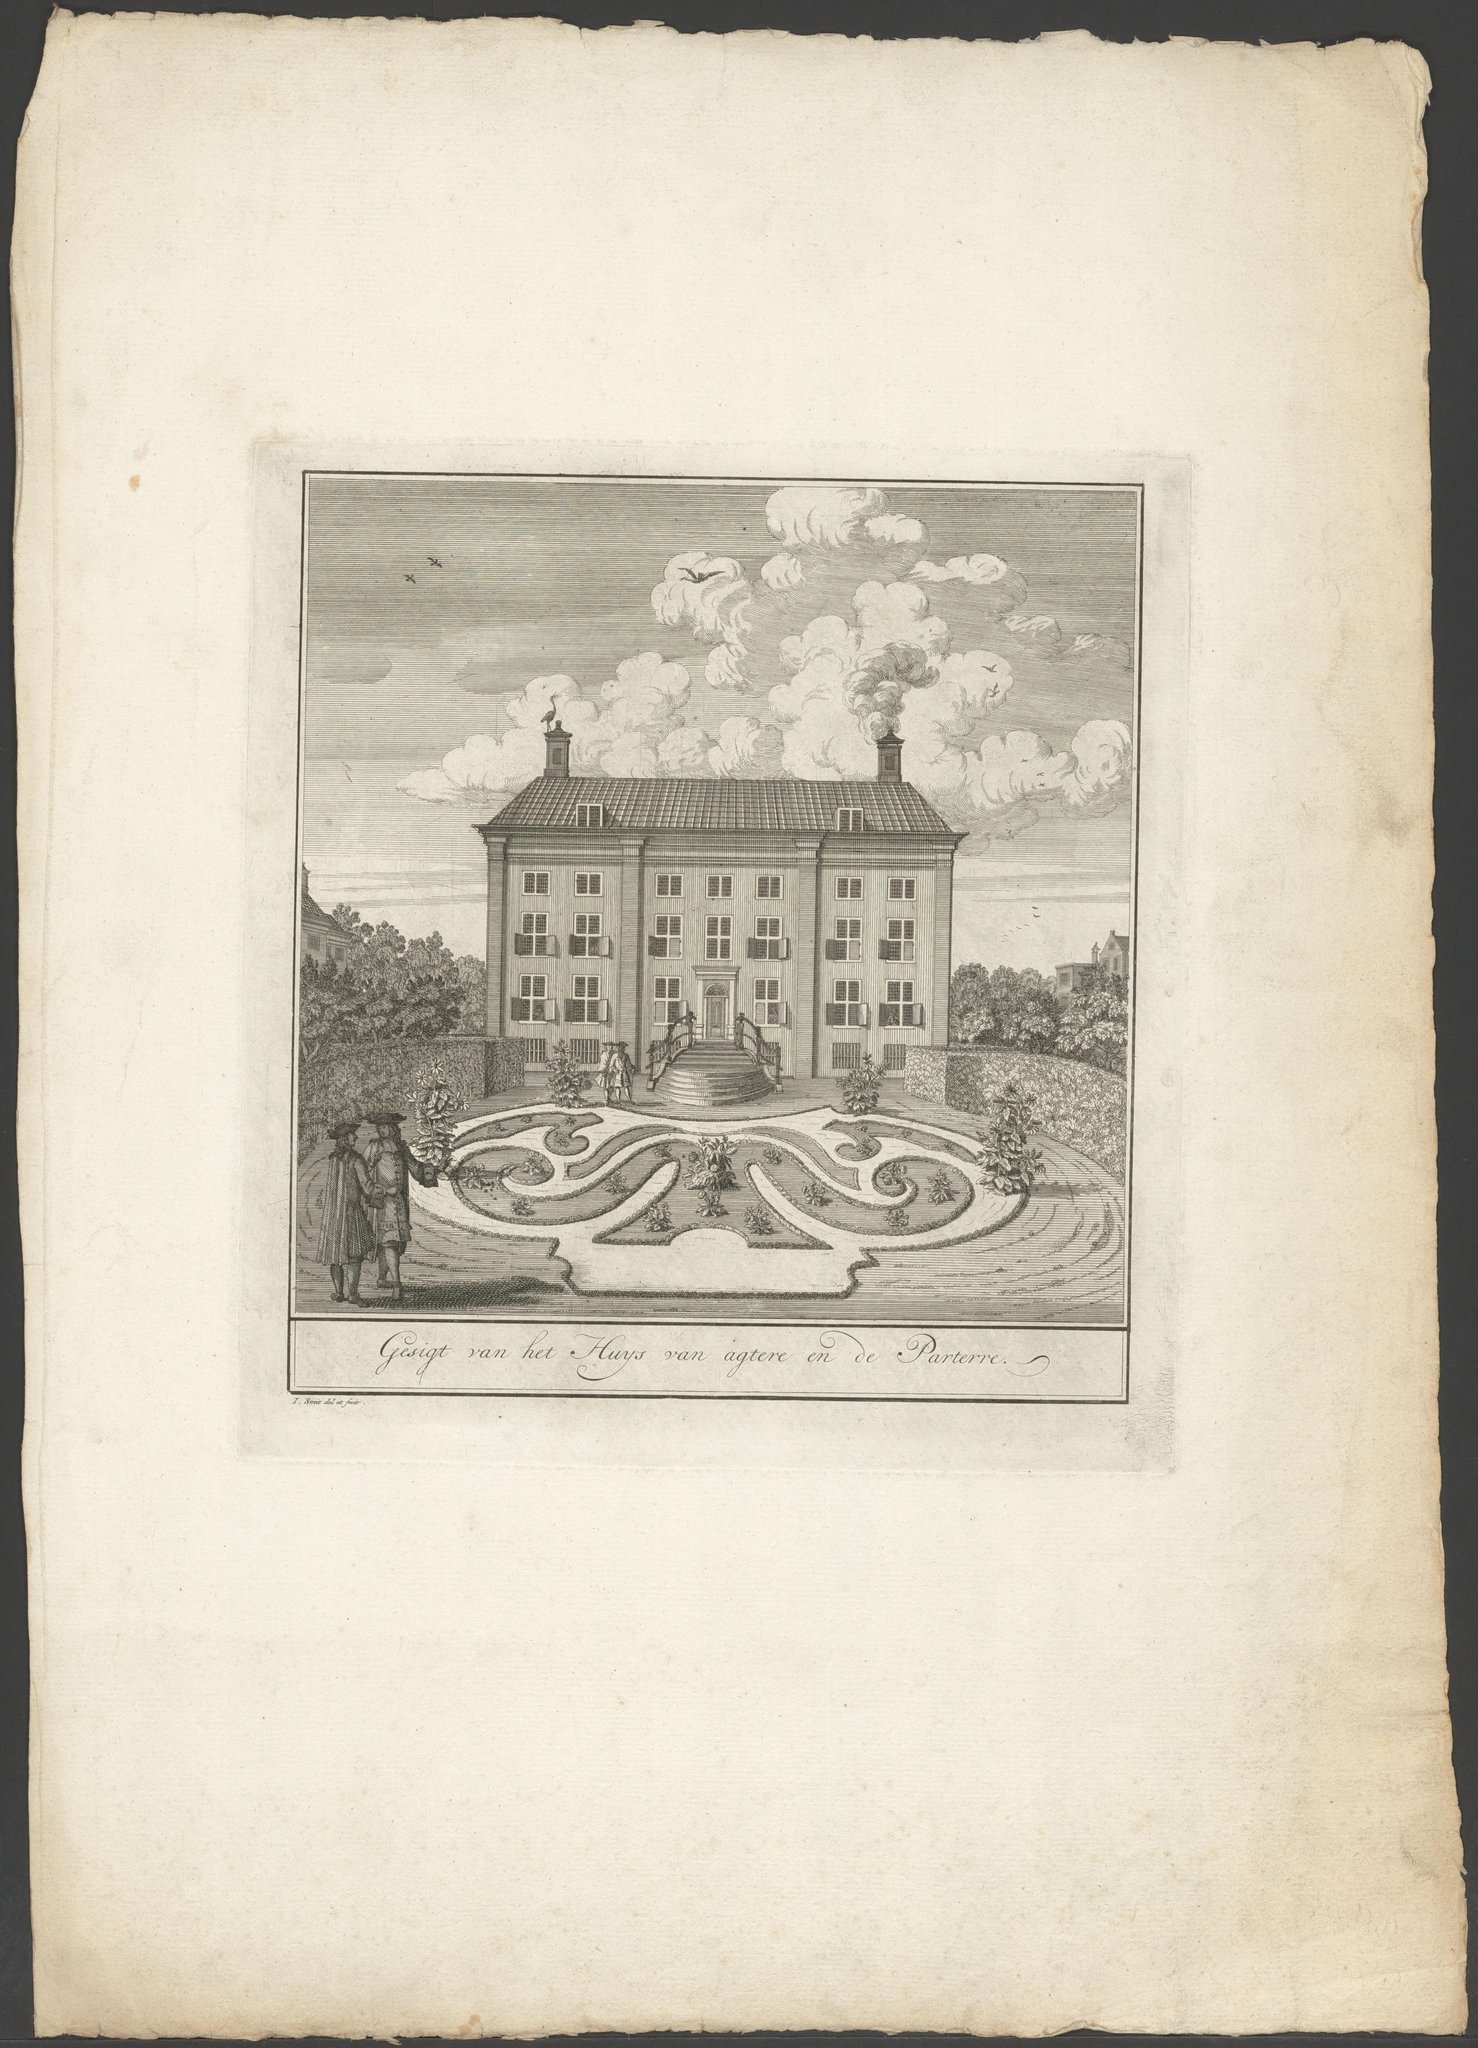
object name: print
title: Gesigt van het Huys van agtere en de Parterre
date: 1723-1748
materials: paper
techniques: engraving, etching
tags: alms-house (dutch: 'hofje'), public welfare, flowers: sunflower, shore-birds and wading-birds: stork, french or architectonic garden; formal garden, old-people's home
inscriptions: collector's mark: Lugt 1641, collector's mark, collector's mark: ‘ARMWEZEN EN LIEFDADIGHEID’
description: Gezicht op de achtergevel en de parterre de broderie van het Corvershof aan de Nieuwe Herengracht te Amsterdam. In de tuin wandelen vier figuren. In de parterres groeien zonnebloemen. Op de linker schoorsteen zit een ooievaar. Onderdeel van een serie prenten van het in 1723 in gebruik genomen Corvershof, bestemd voor oudere echtparen van Nederduits Gereformeerde (later Hervormde) huize. Onderwerpsrubrieken binnen de Atlas Zeden en Gewoonten: Armwezen en Liefdadigheid.